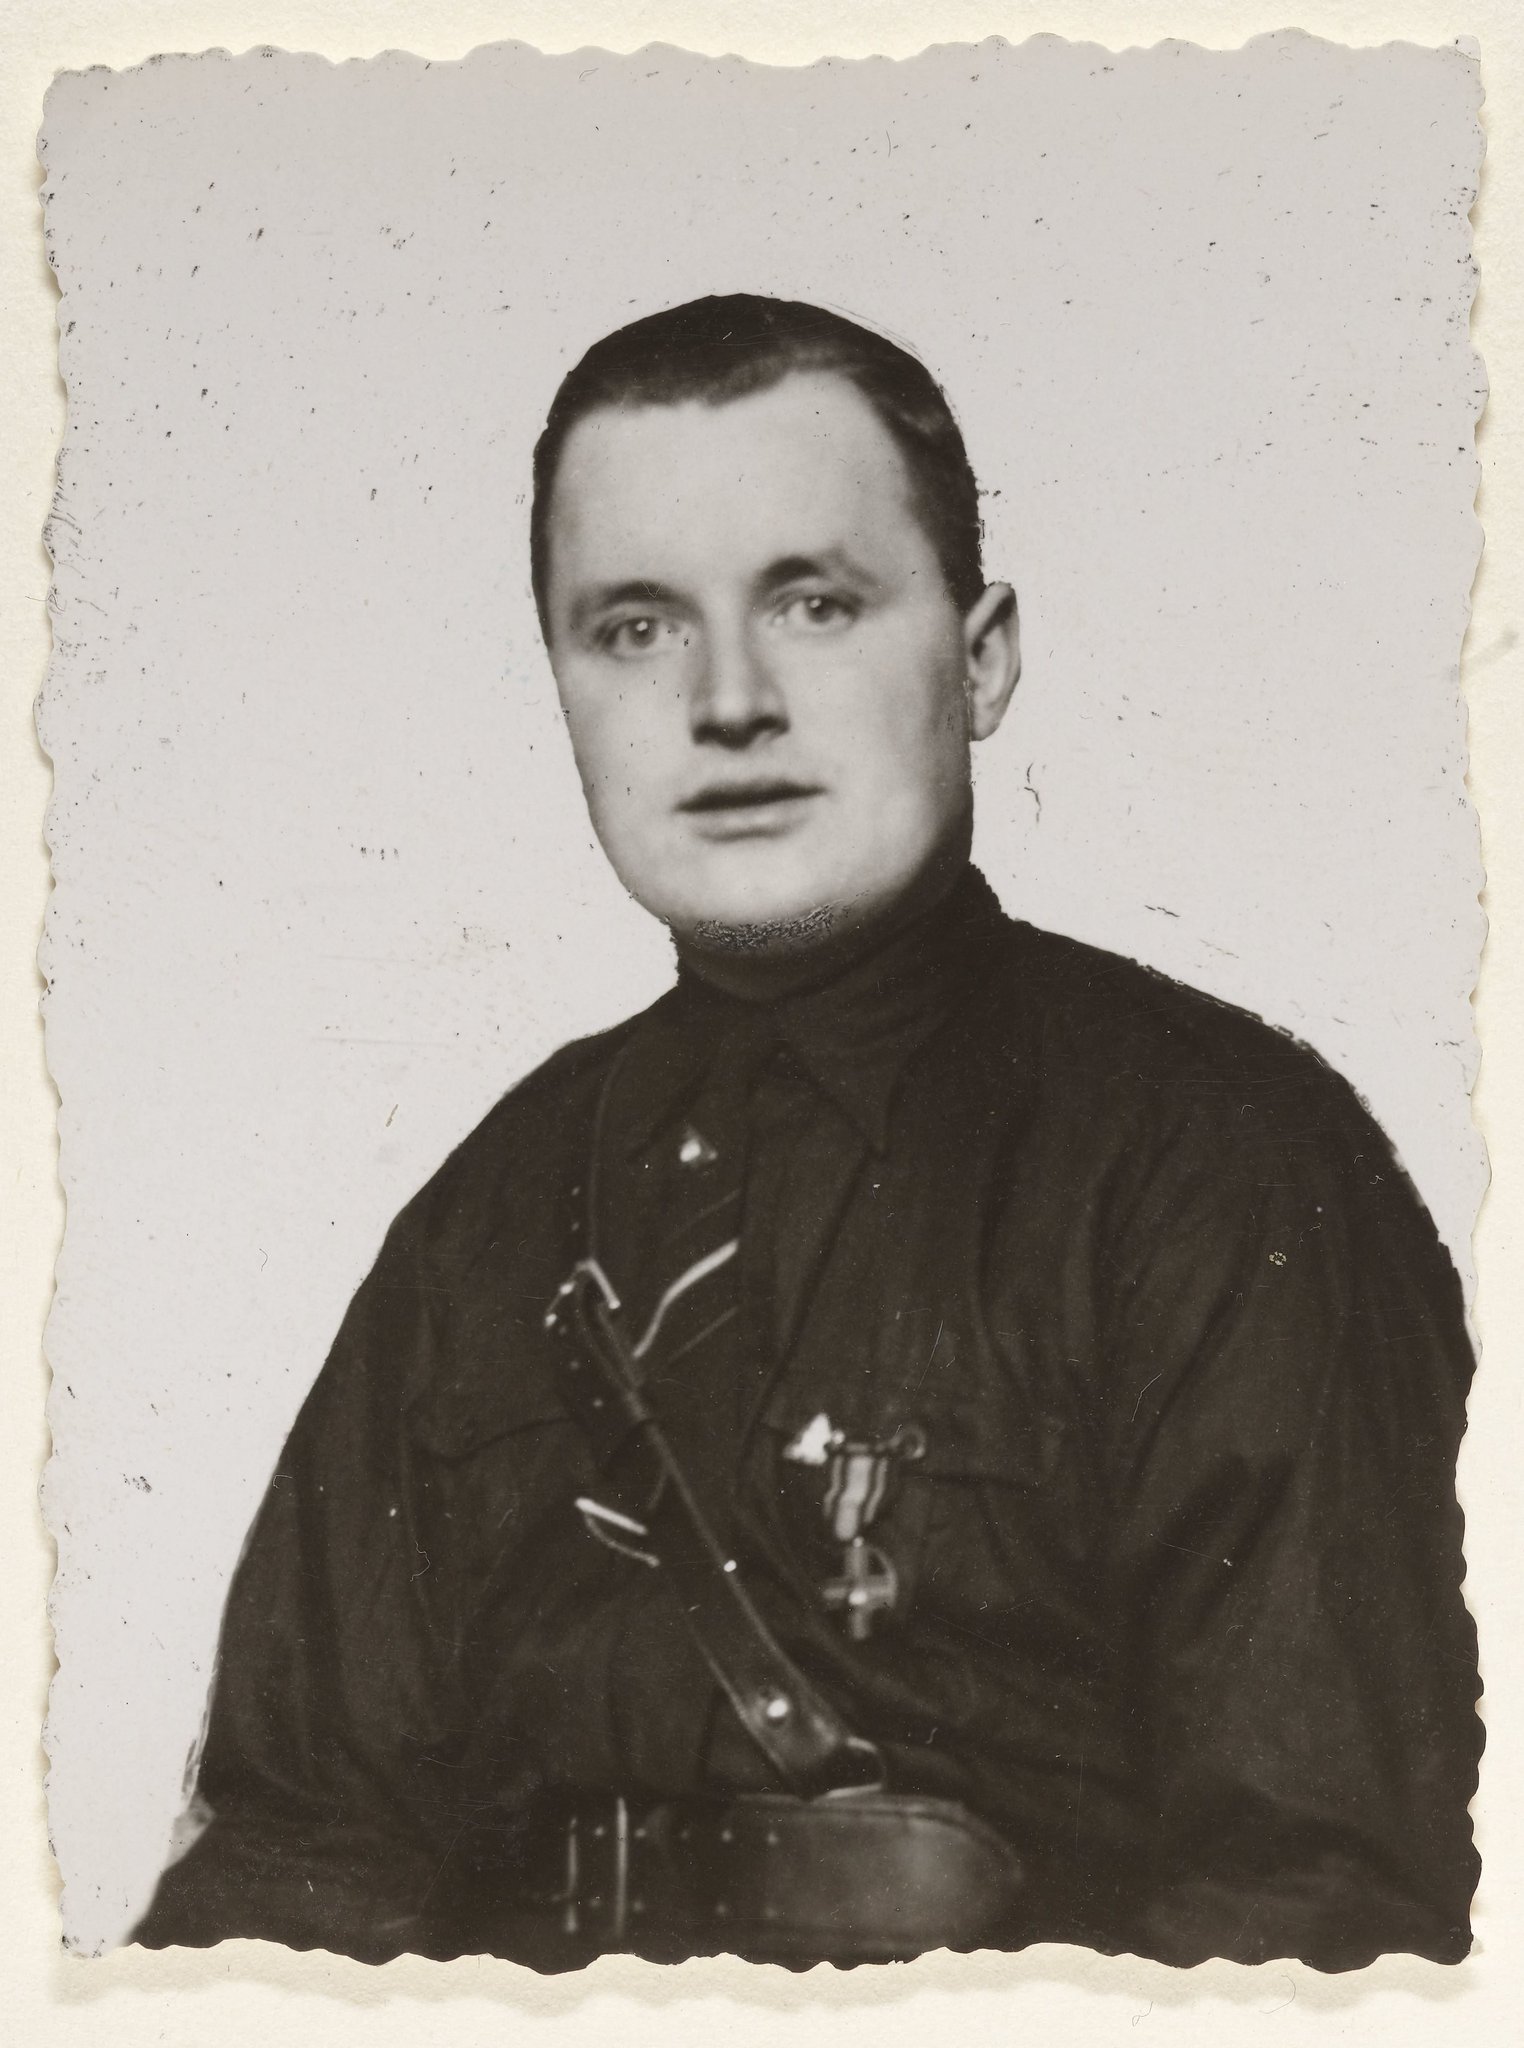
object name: contact print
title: Portret van een lid van de WA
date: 1940-1944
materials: photographic support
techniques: photography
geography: netherlands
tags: anonymous historical person portrayed, netherlands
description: Portret van een lid van de WA. Gekleed in zwart hemd, brede riem en een riem schuin over de borst. Links draagt hij een onderscheiding. Blootshoofd.